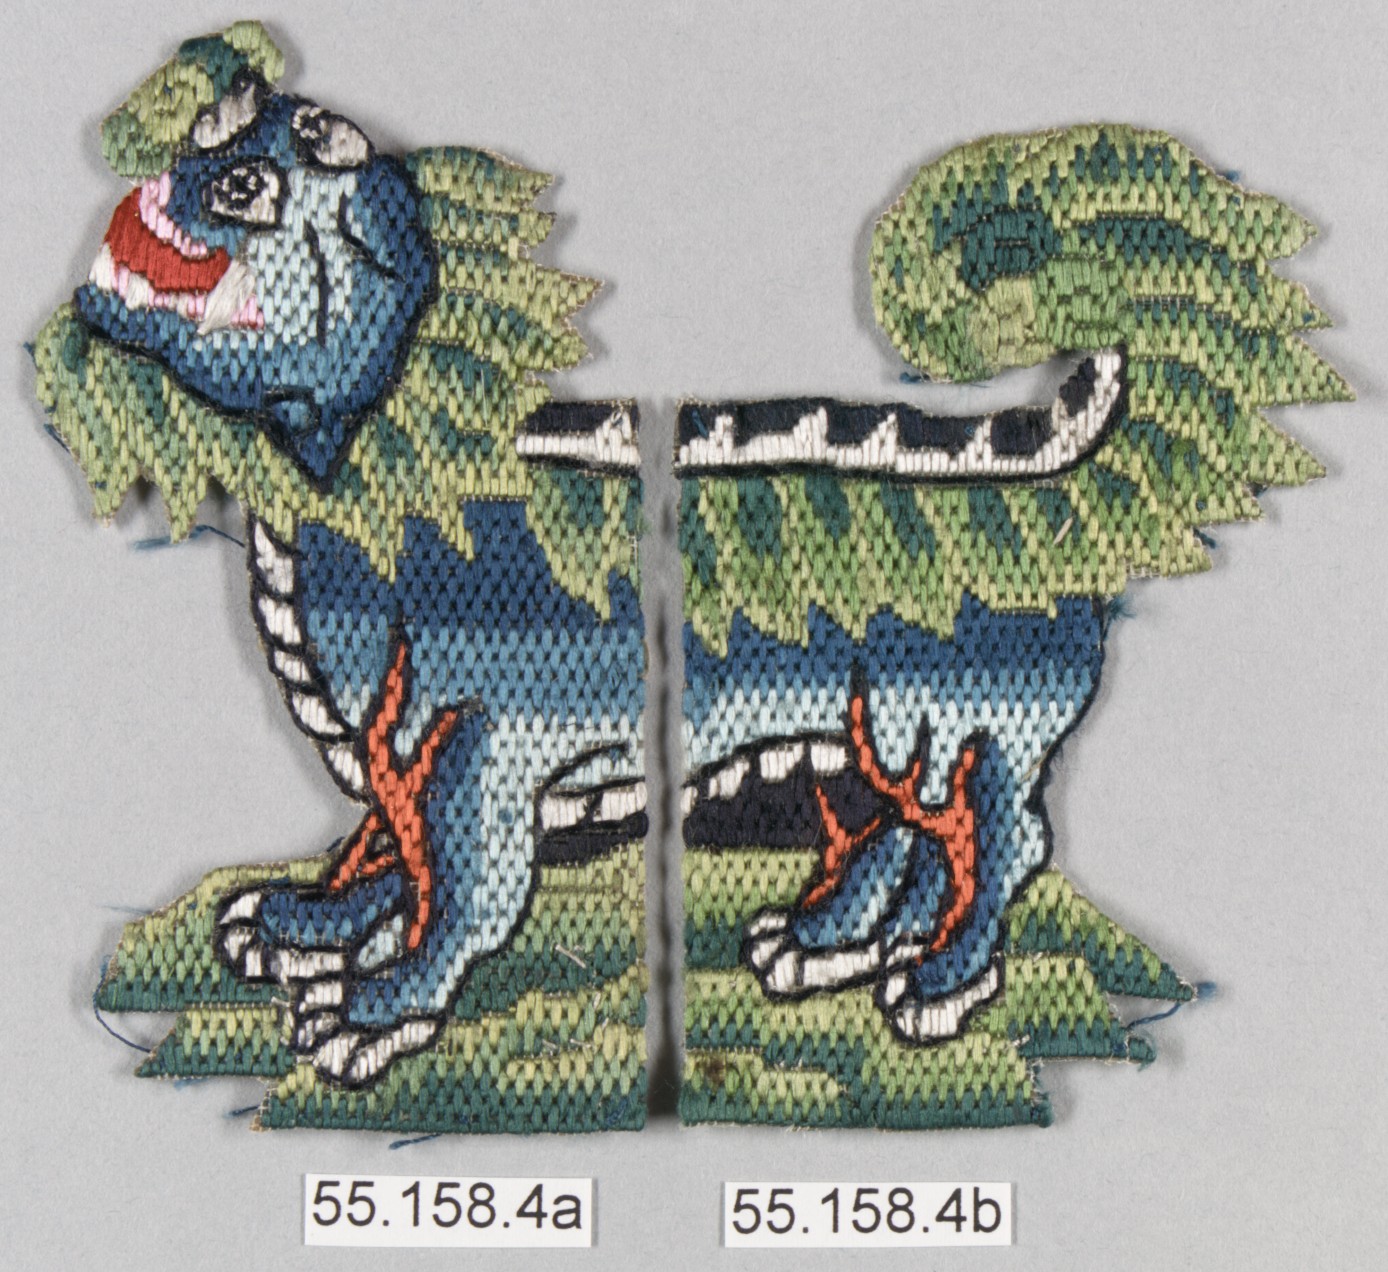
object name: appliqué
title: Applique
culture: chinese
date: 1867-1933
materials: silk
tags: animals